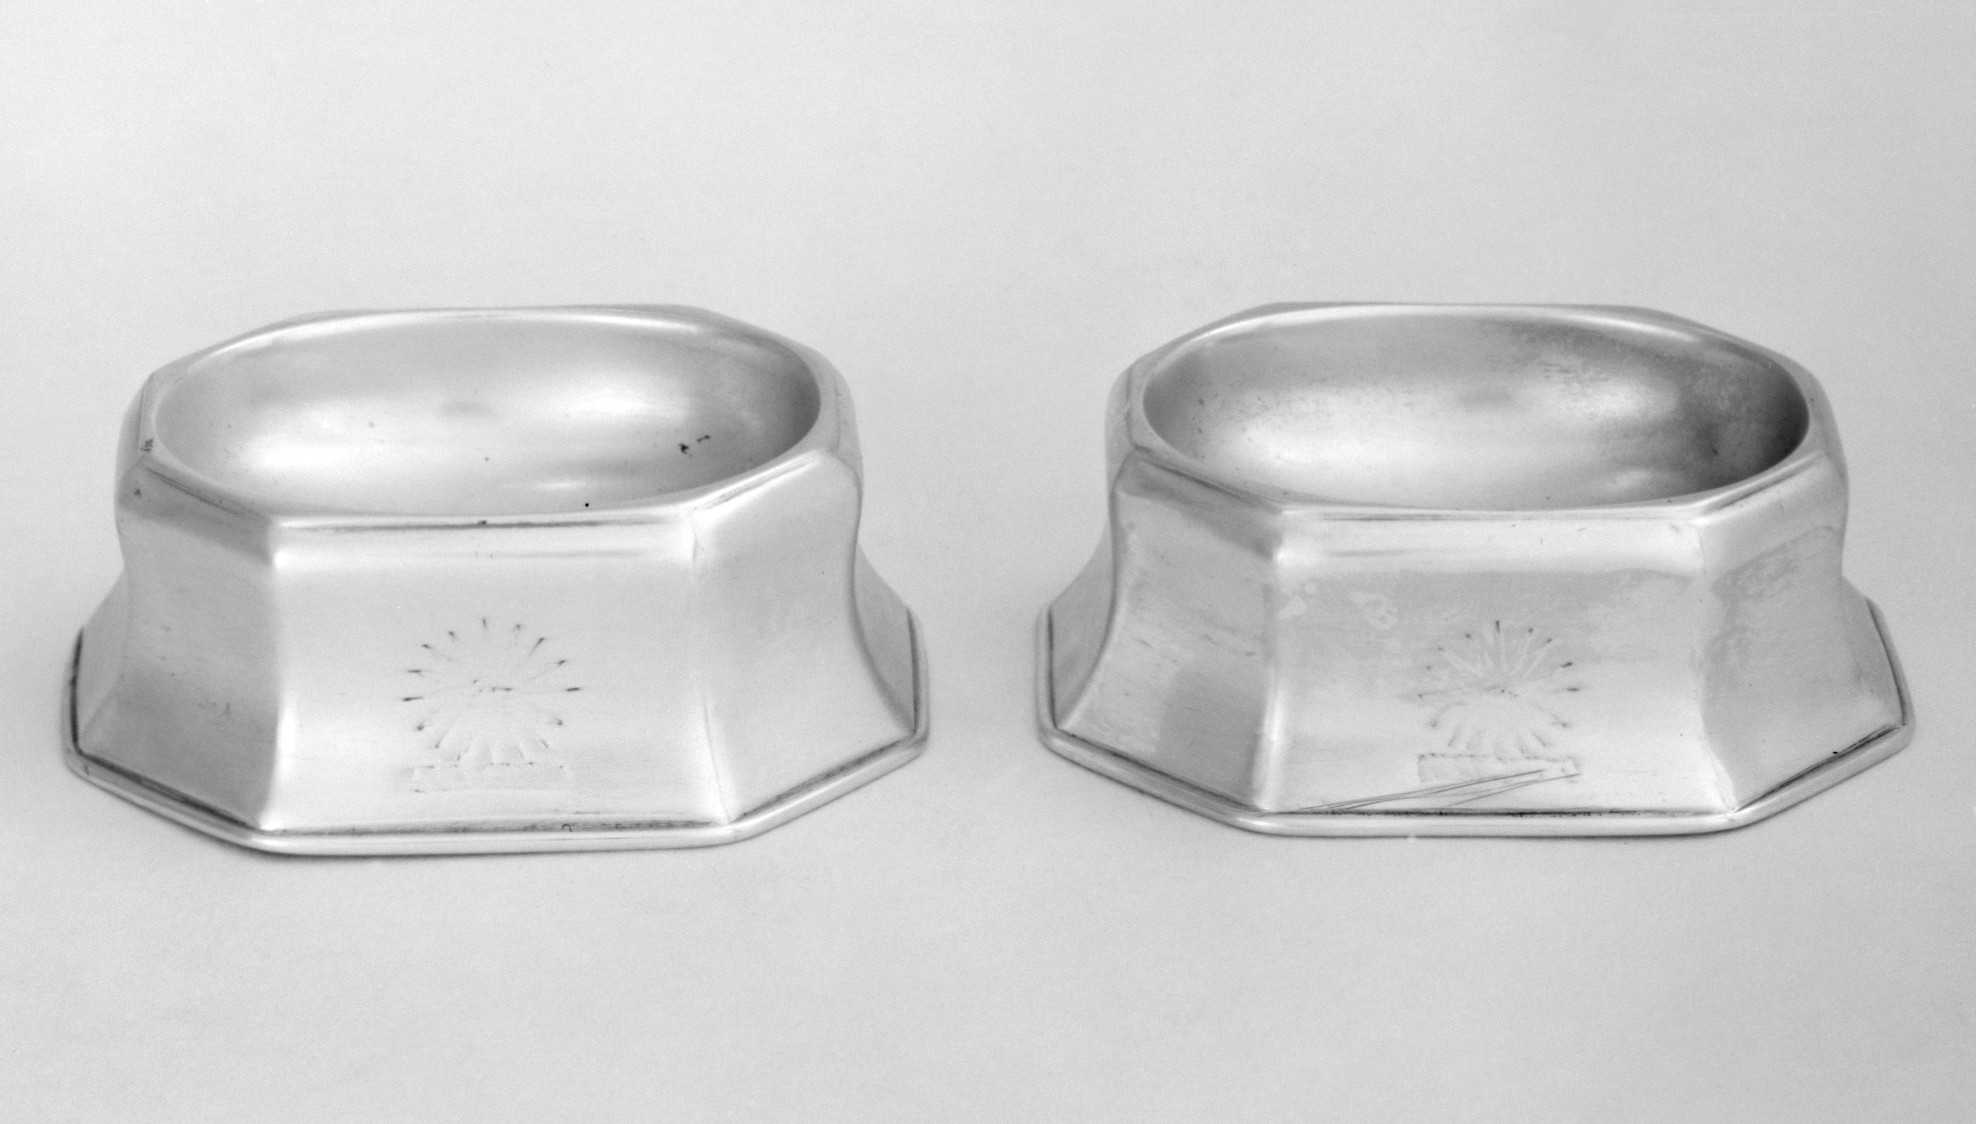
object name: salt trencher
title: Pair of salt trenchers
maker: thomas ash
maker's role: maker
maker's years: 1652-1712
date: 1714-1715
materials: silver